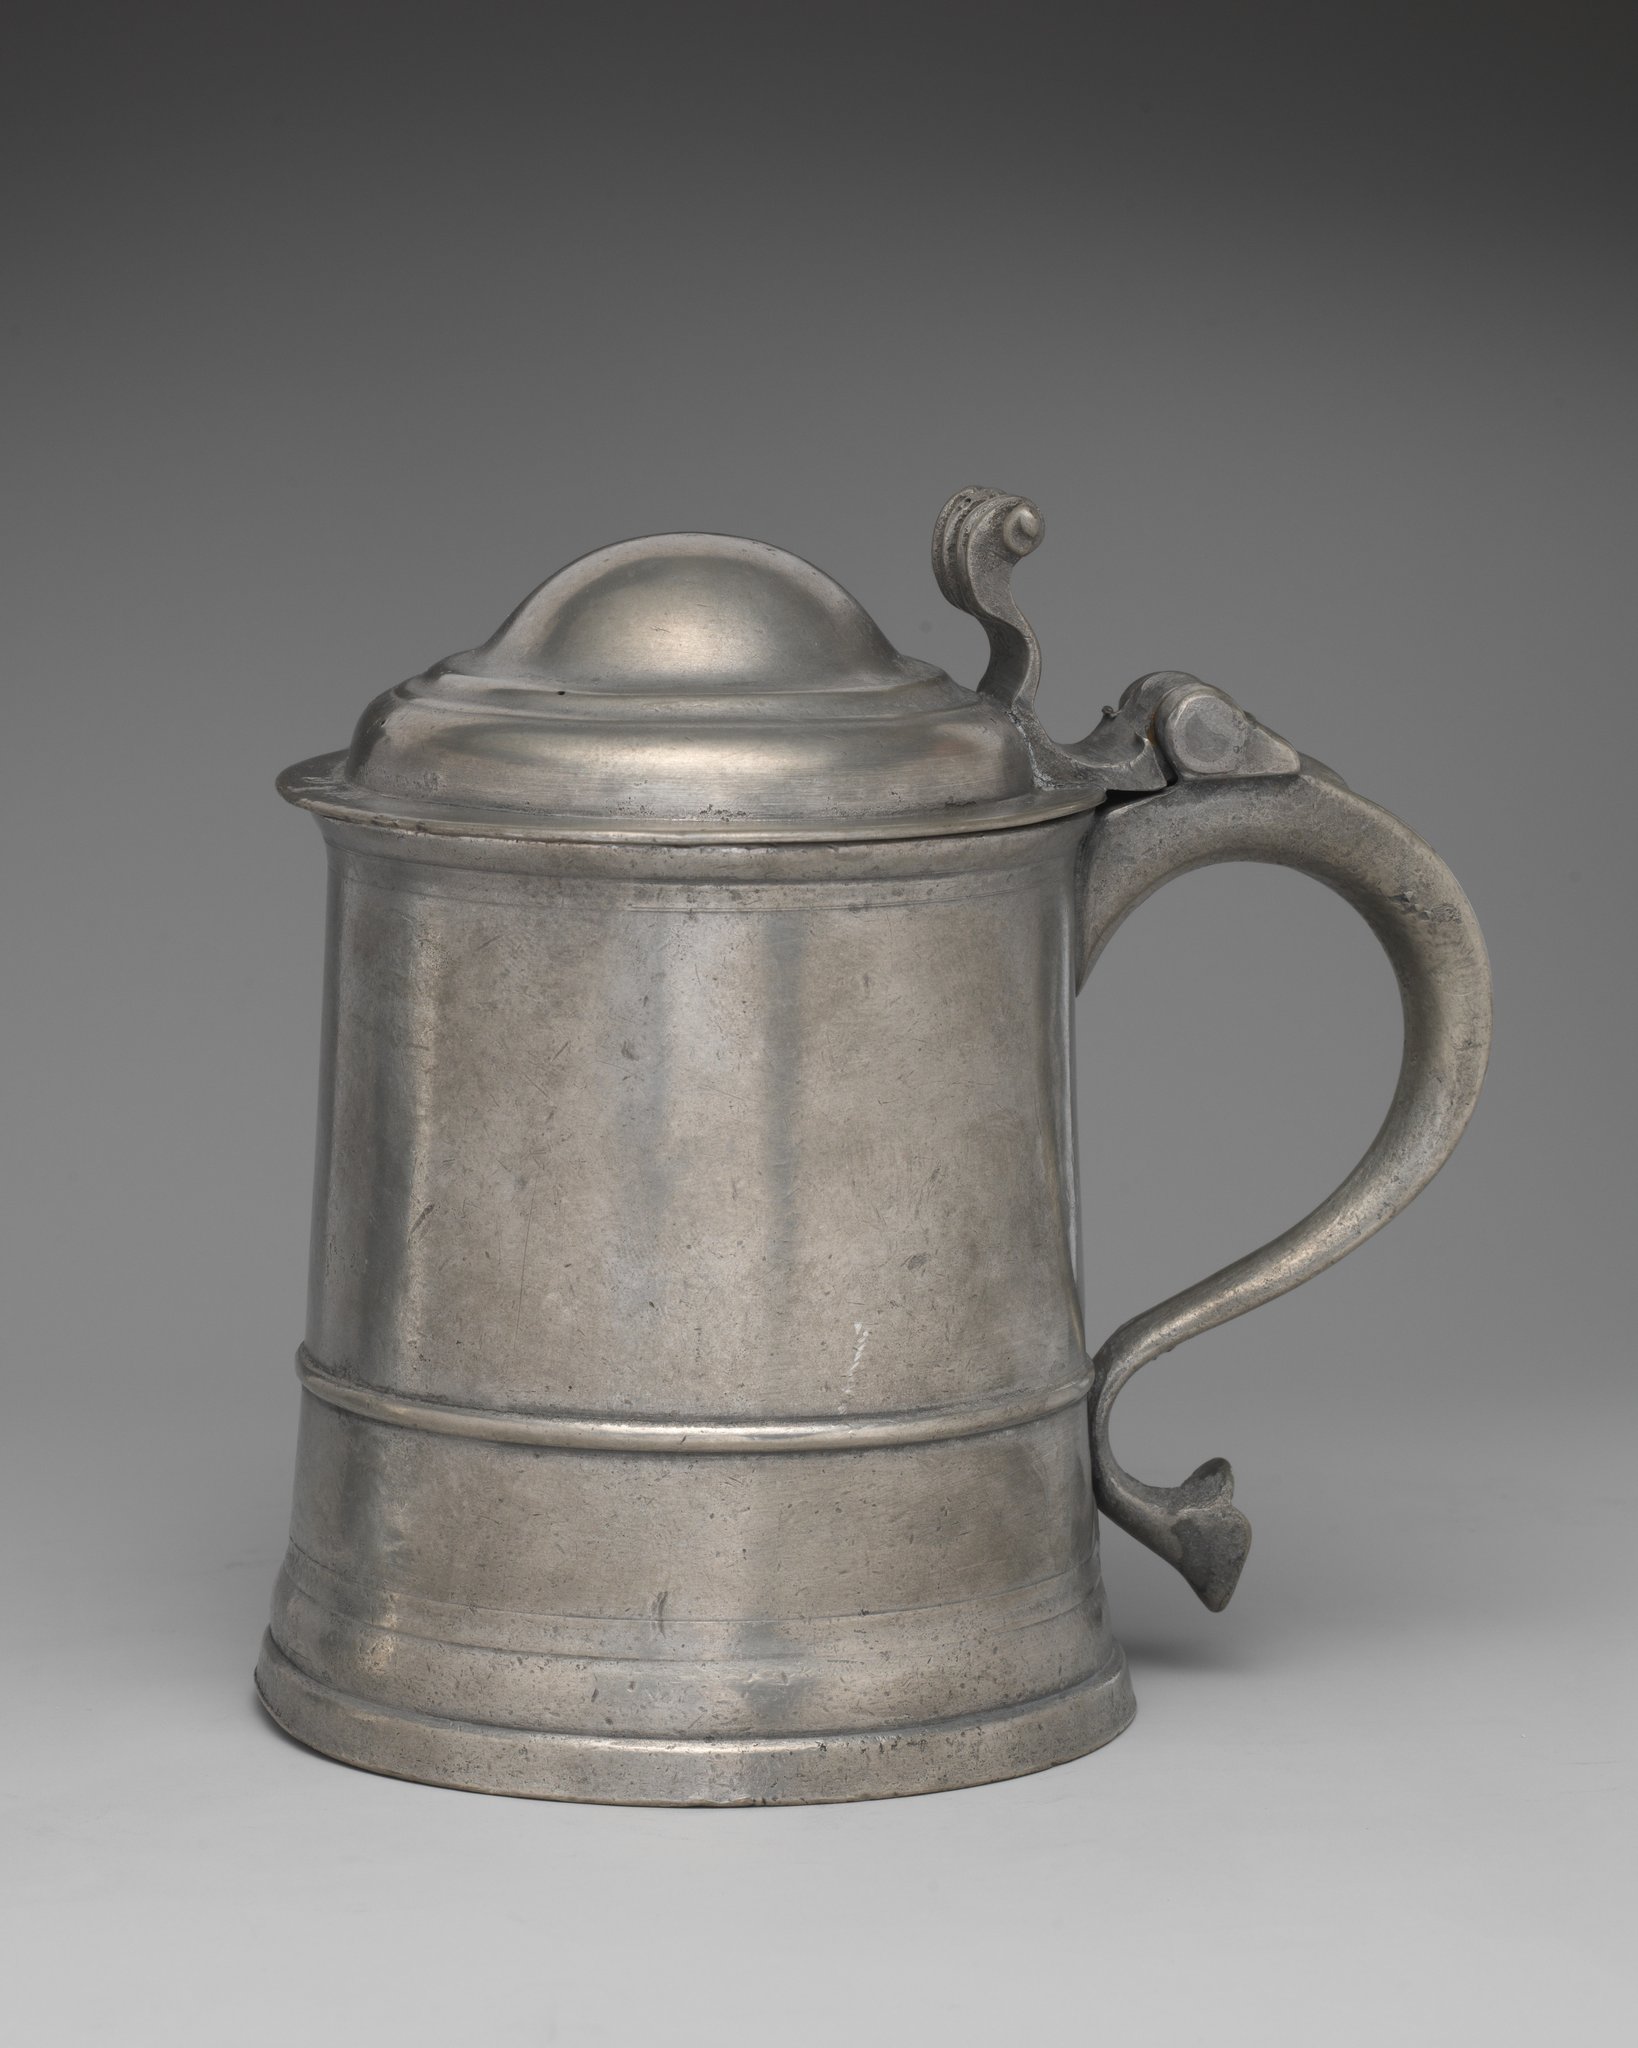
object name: tankard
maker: richard going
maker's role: maker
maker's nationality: british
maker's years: 1670-1770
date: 1701-1800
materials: pewter